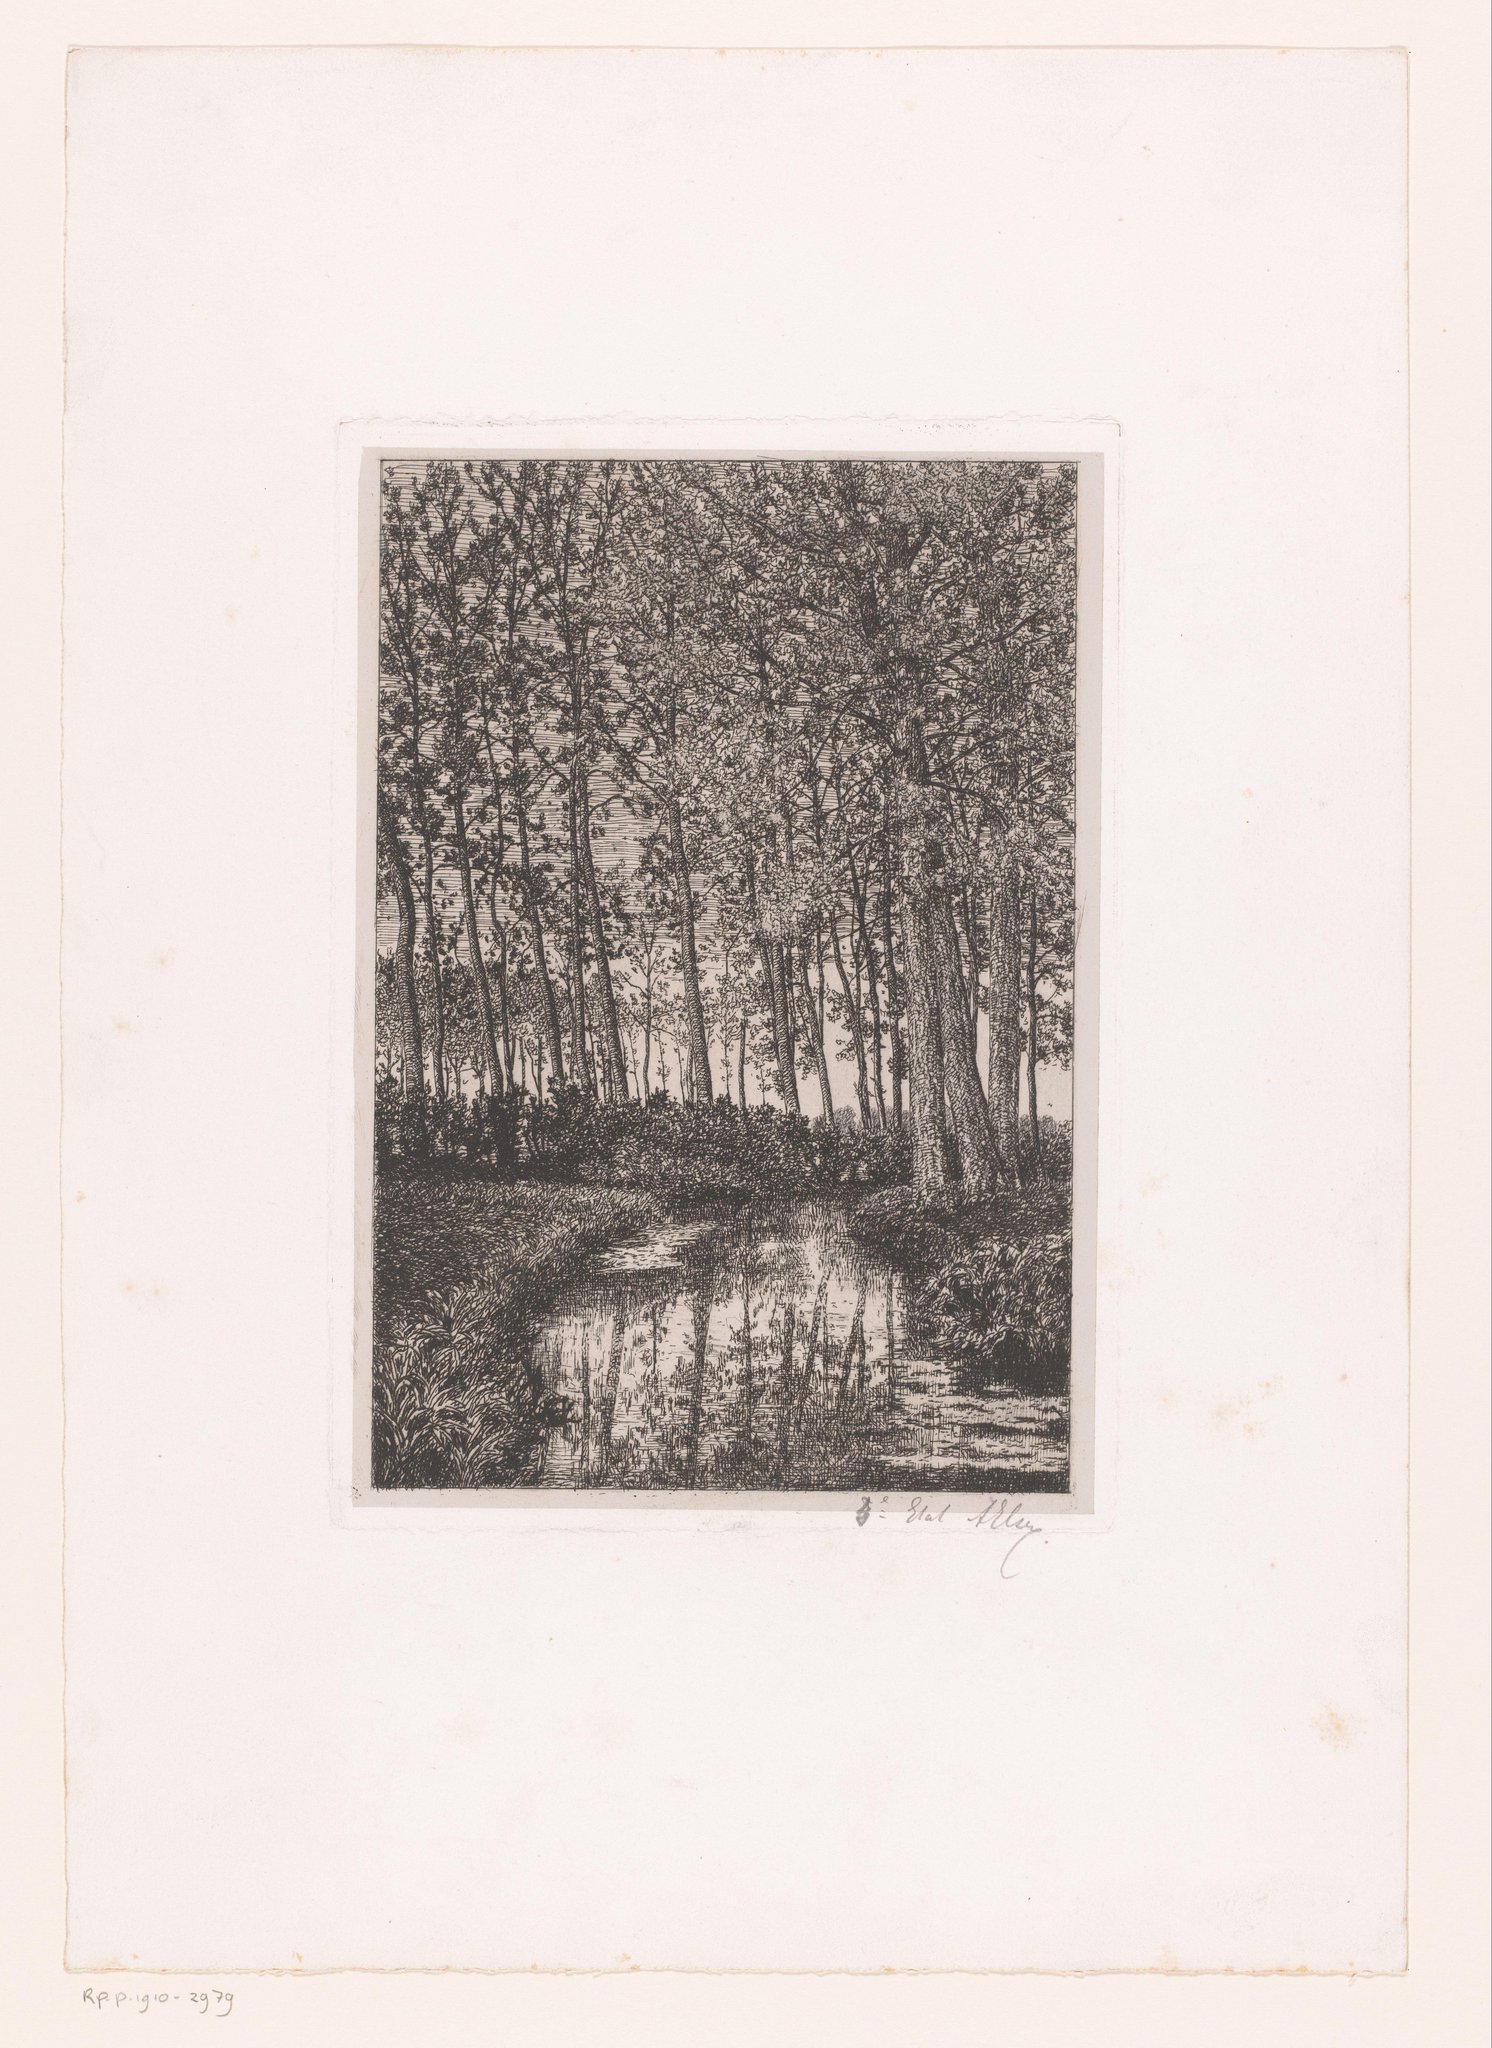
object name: print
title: Hoge bomen aan het water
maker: alfred elsen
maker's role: painter, print maker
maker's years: 1850-1914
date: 1860-1910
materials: paper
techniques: etching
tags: trees, landscapes with waters, waterscapes, seascapes (in the temperate zone)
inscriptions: inscription: ‘3e Etat’, collector's mark: Lugt 2228